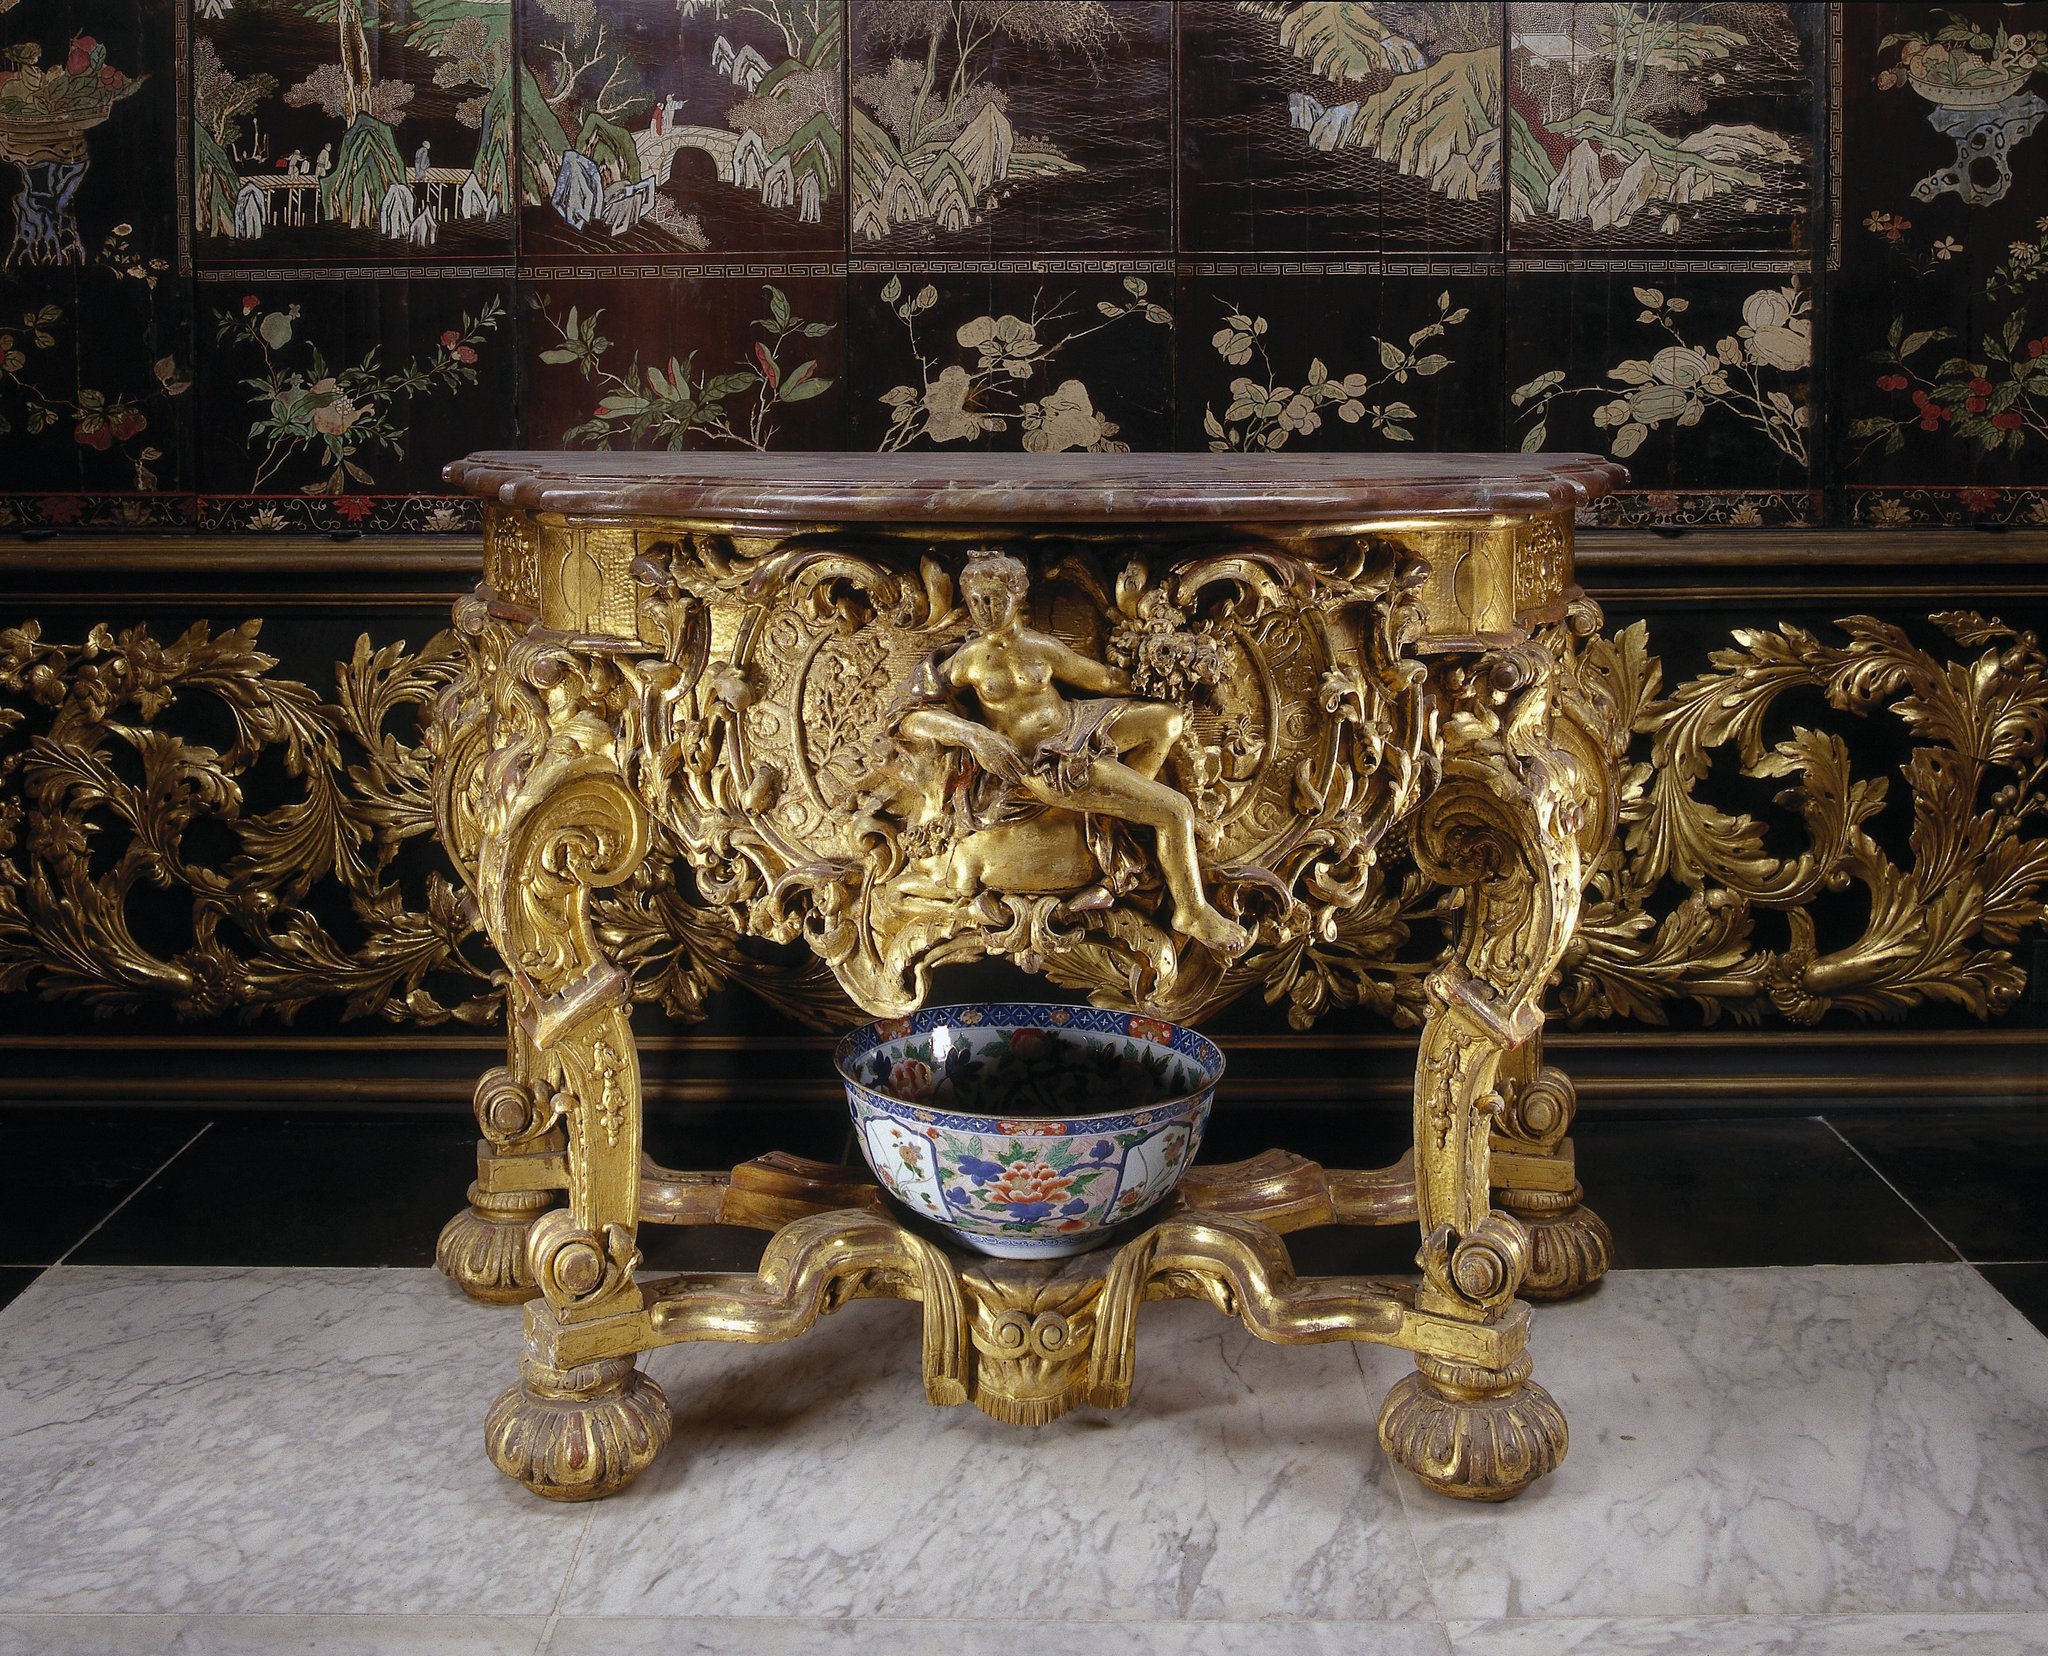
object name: furniture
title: Wandtafel van verguld lindehout met aan de voorkant Europa op de stier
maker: Anonymous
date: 1690-1710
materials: wood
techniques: gilding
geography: northern netherlands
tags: jupiter, usually in the shape of a white bull, abducts europa and carries her across the water, foliage, tendrils, branches ~ ornament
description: Side table. Gilt lime. Depiction of Europa and the bull. Northern Netherlands, c. 1700. Presented by the Committee for Photo Sales.